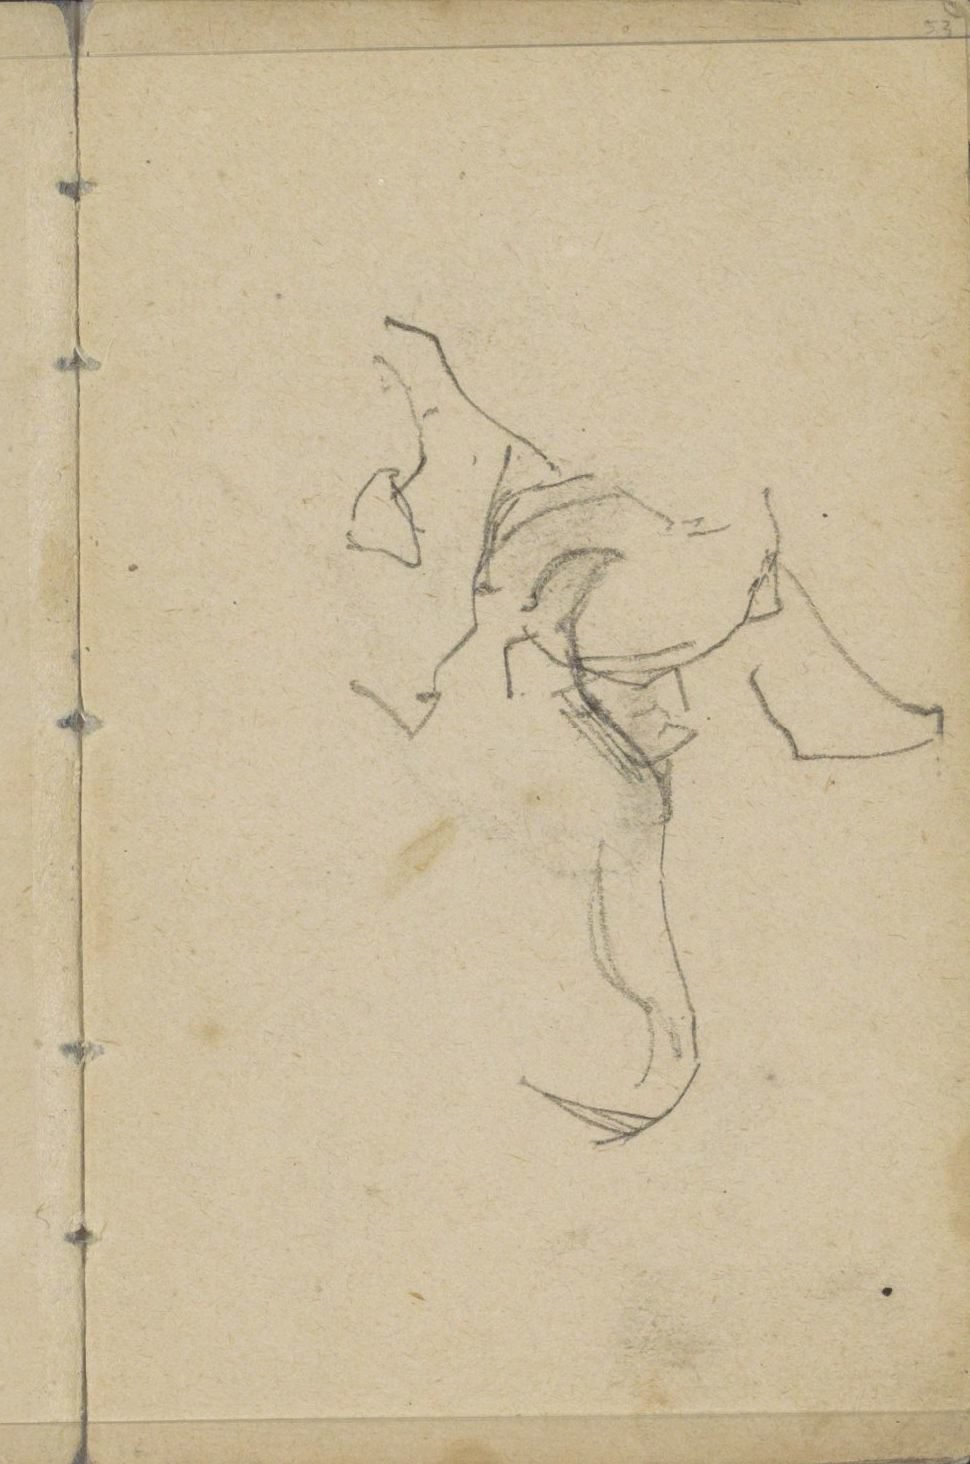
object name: sketchbook leaf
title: Studie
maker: george hendrik breitner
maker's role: draughtsman, painter, print maker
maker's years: 1857-1923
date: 1881-1883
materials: chalk, paper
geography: south holland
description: Studie. Pagina 53 uit een schetsboek met 43 bladen.